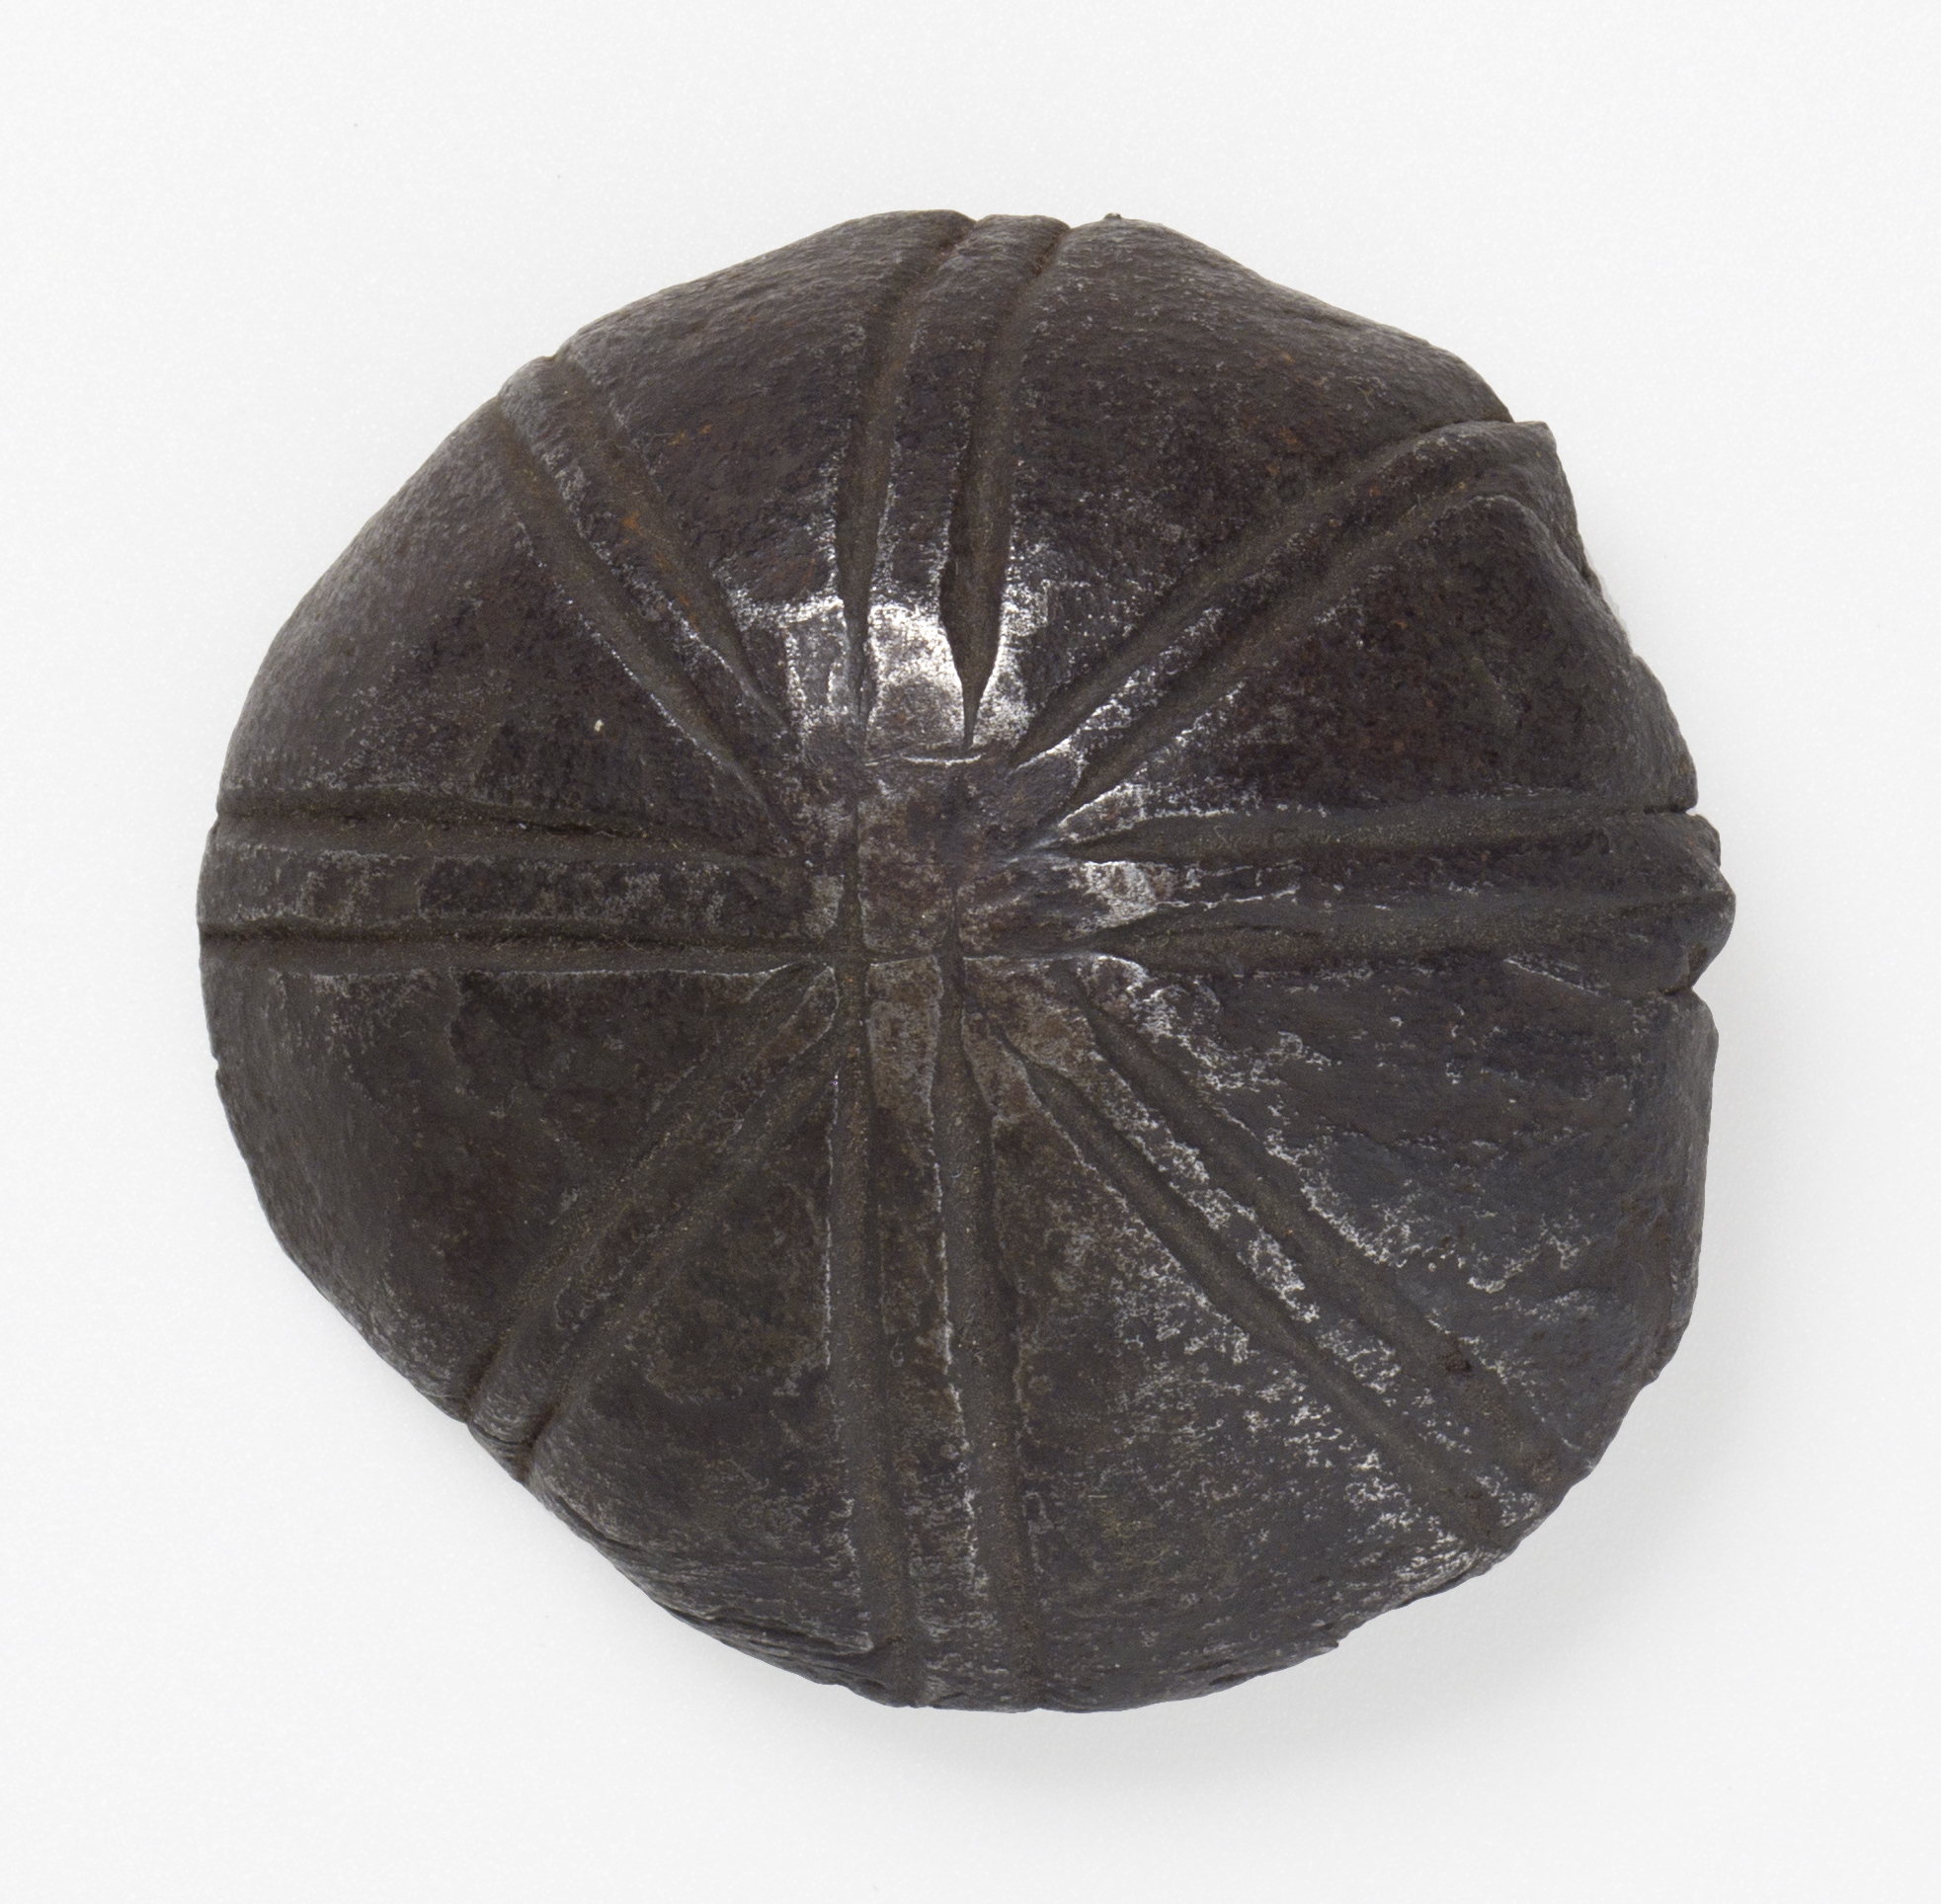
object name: nail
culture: european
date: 1401-1600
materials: iron